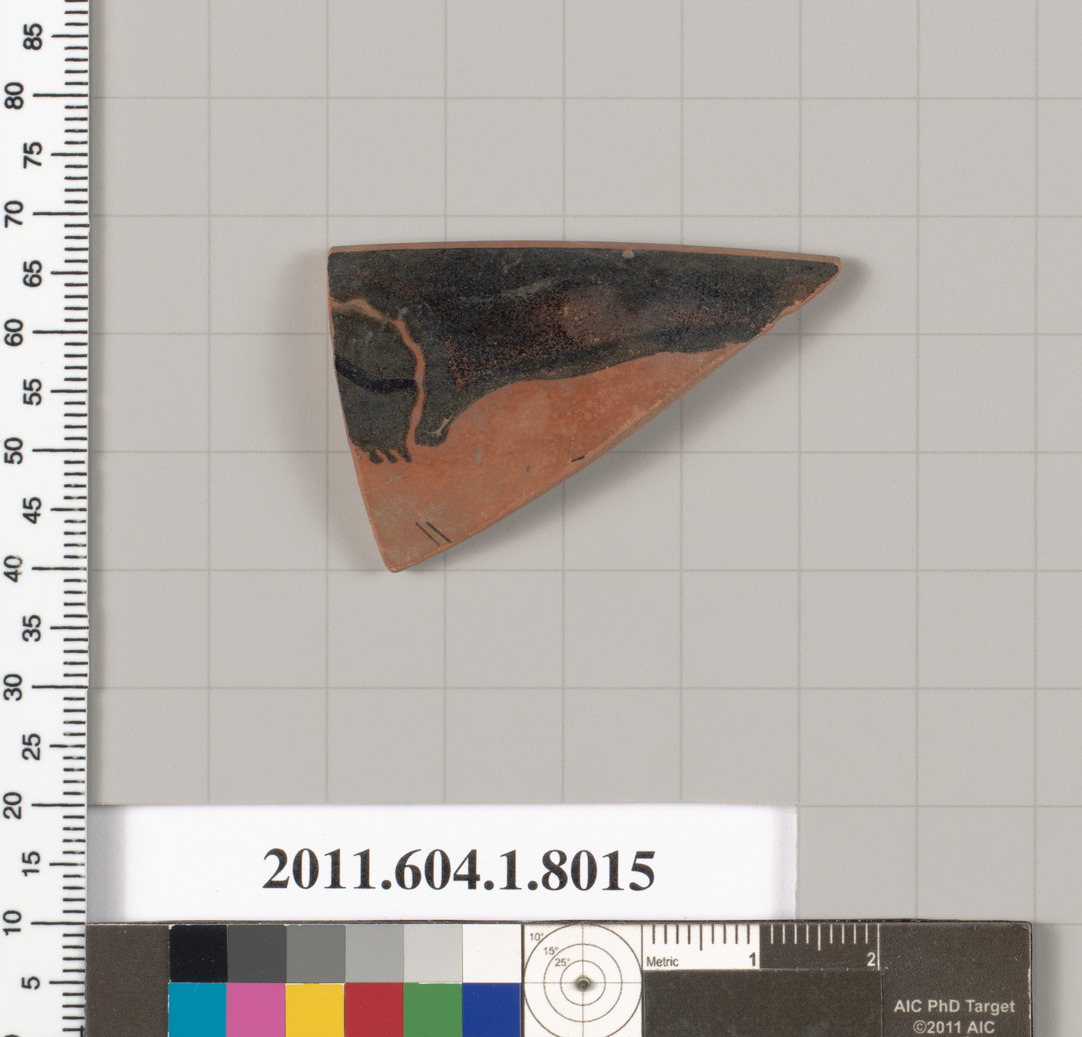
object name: kylix fragment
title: Terracotta rim fragment of a kylix (drinking cup)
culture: greek, attic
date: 510-500 BCE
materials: terracotta